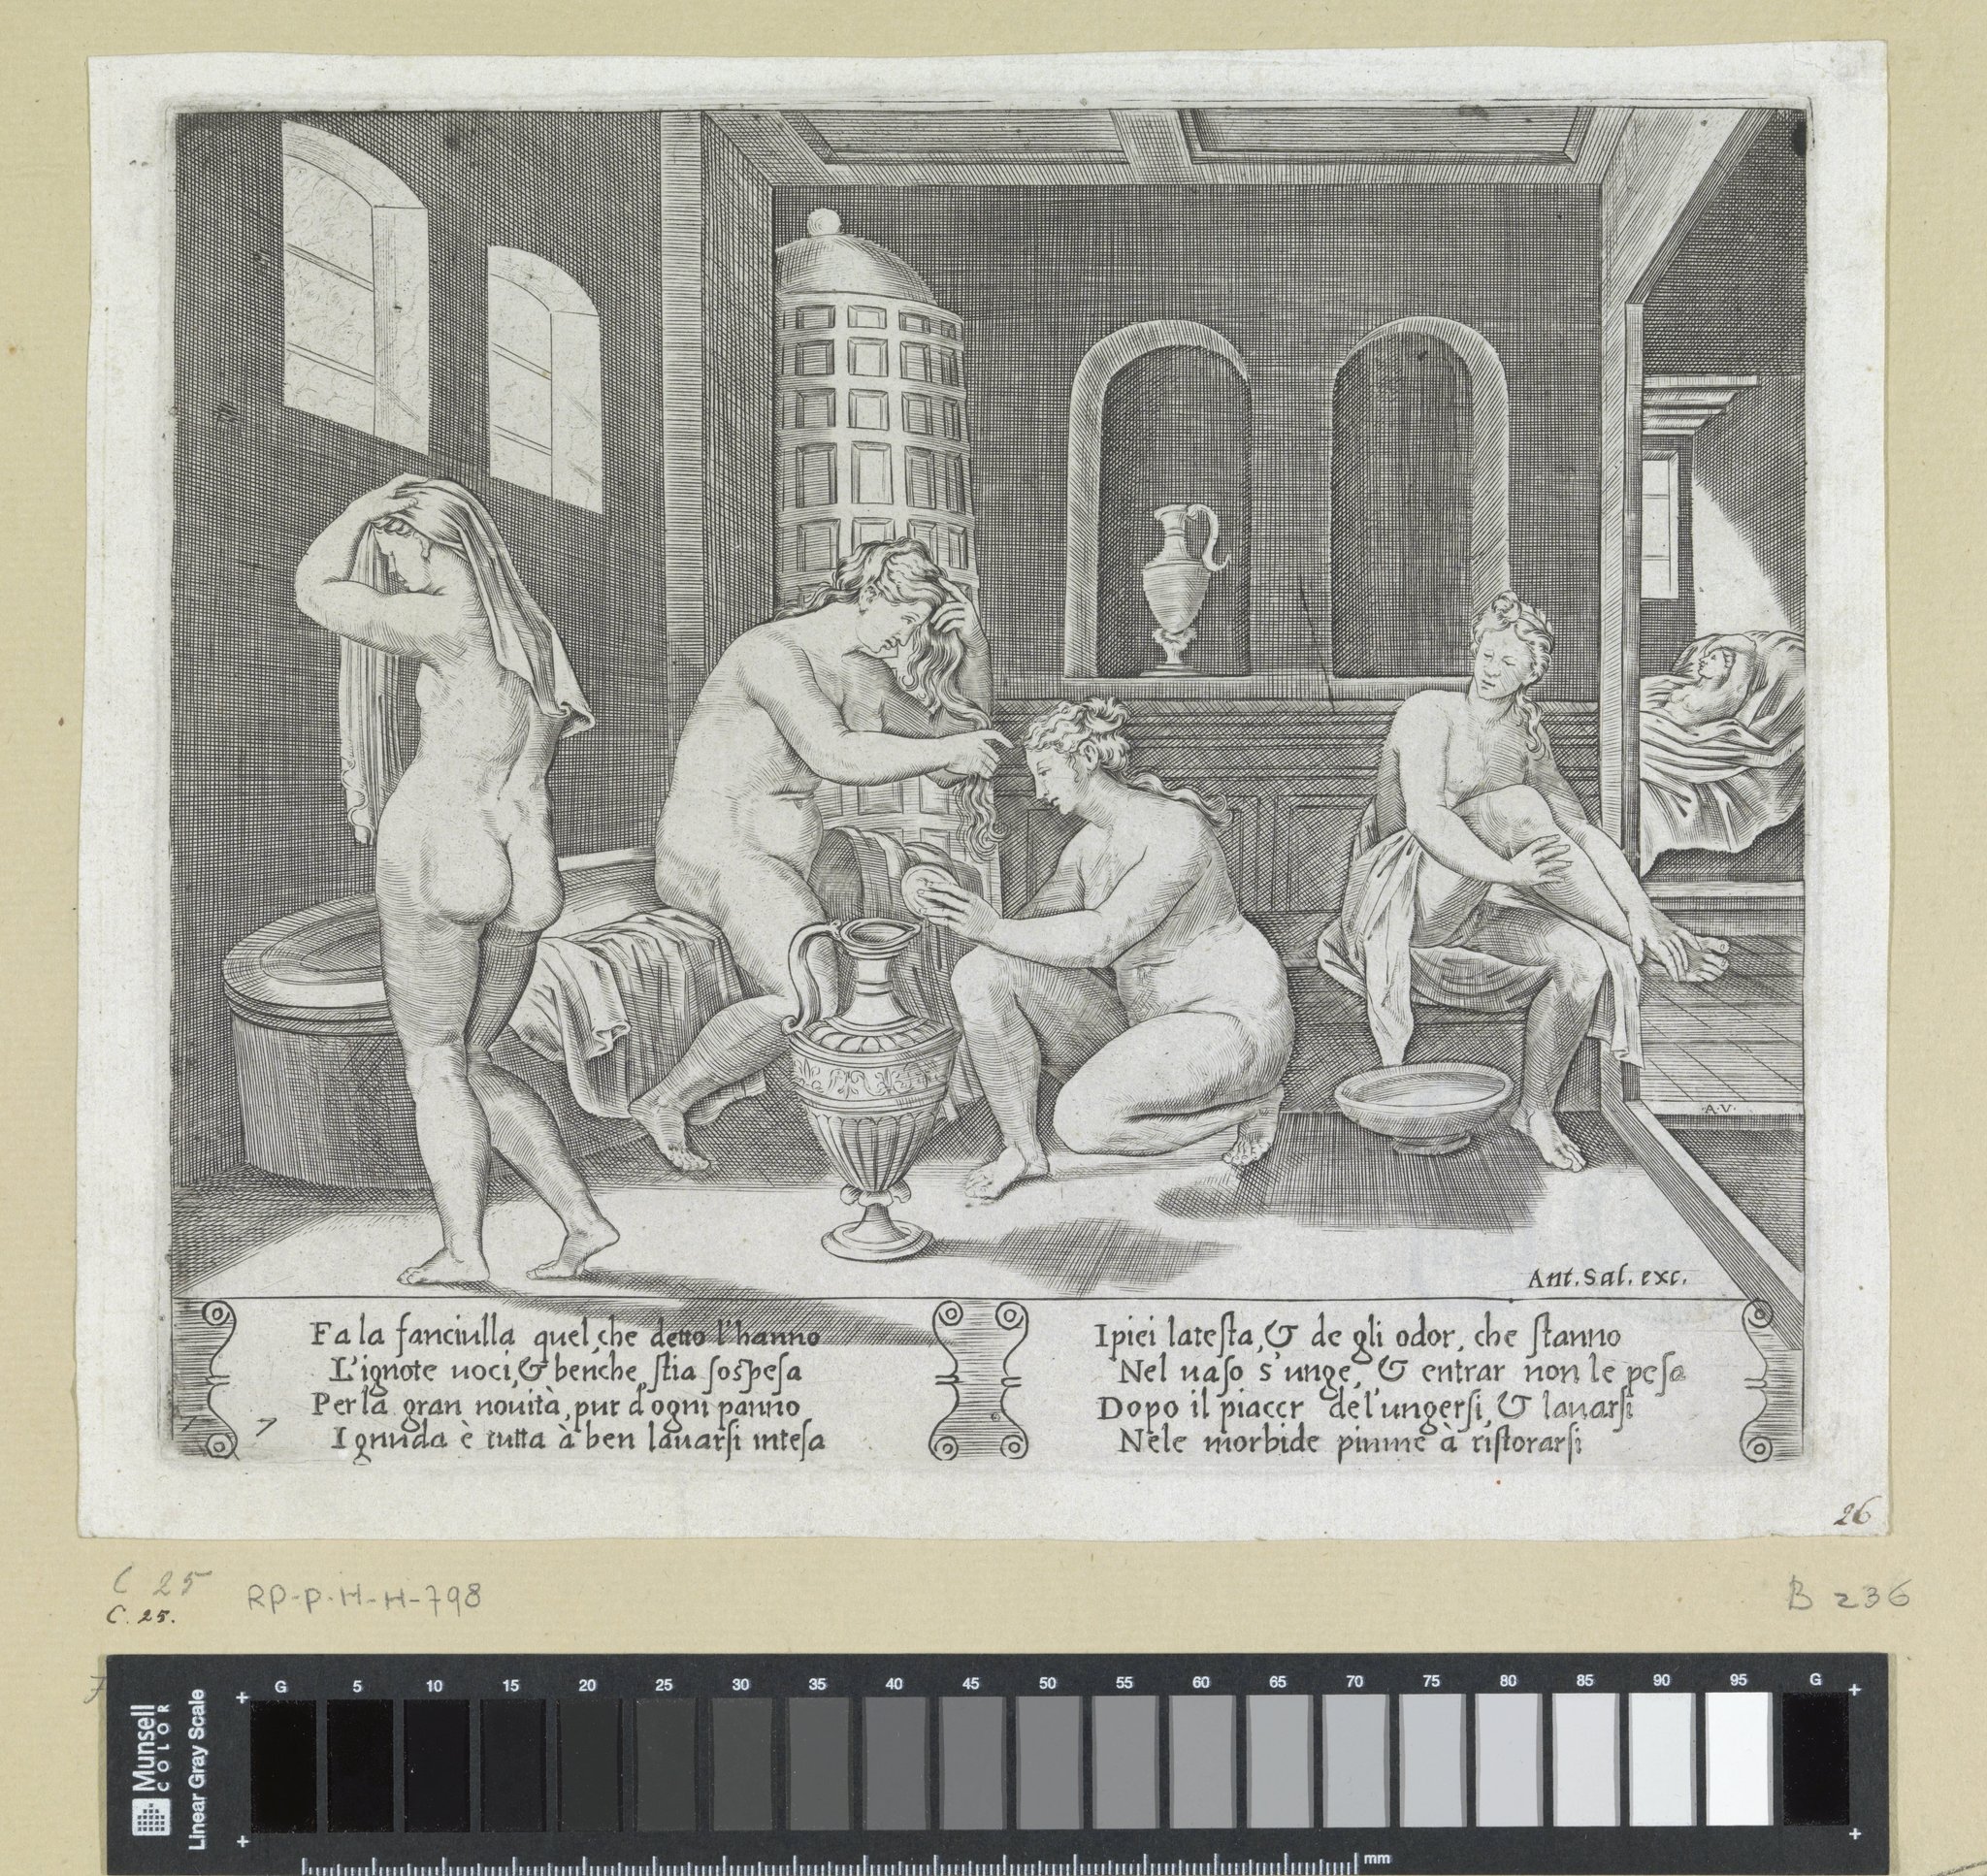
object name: print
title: Badende Psyche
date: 1500-1536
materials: paper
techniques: engraving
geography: rome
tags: taking a bath, other scenes from the story of cupid and psyche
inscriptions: collector's mark: Lugt 11, number: ‘26’, collector's mark: Lugt 10, collector's mark: ‘Hinloopen’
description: Psyche zittend op de rand van een bad, met om haar heen drie nimfen die voor haar onzichtbaar zijn. Rechts een doorkijk naar Psyche liggend in haar bed. Italiaanse tekst in twee cartouches in ondermarge. Tweemaal genummerd linksonder: 7.